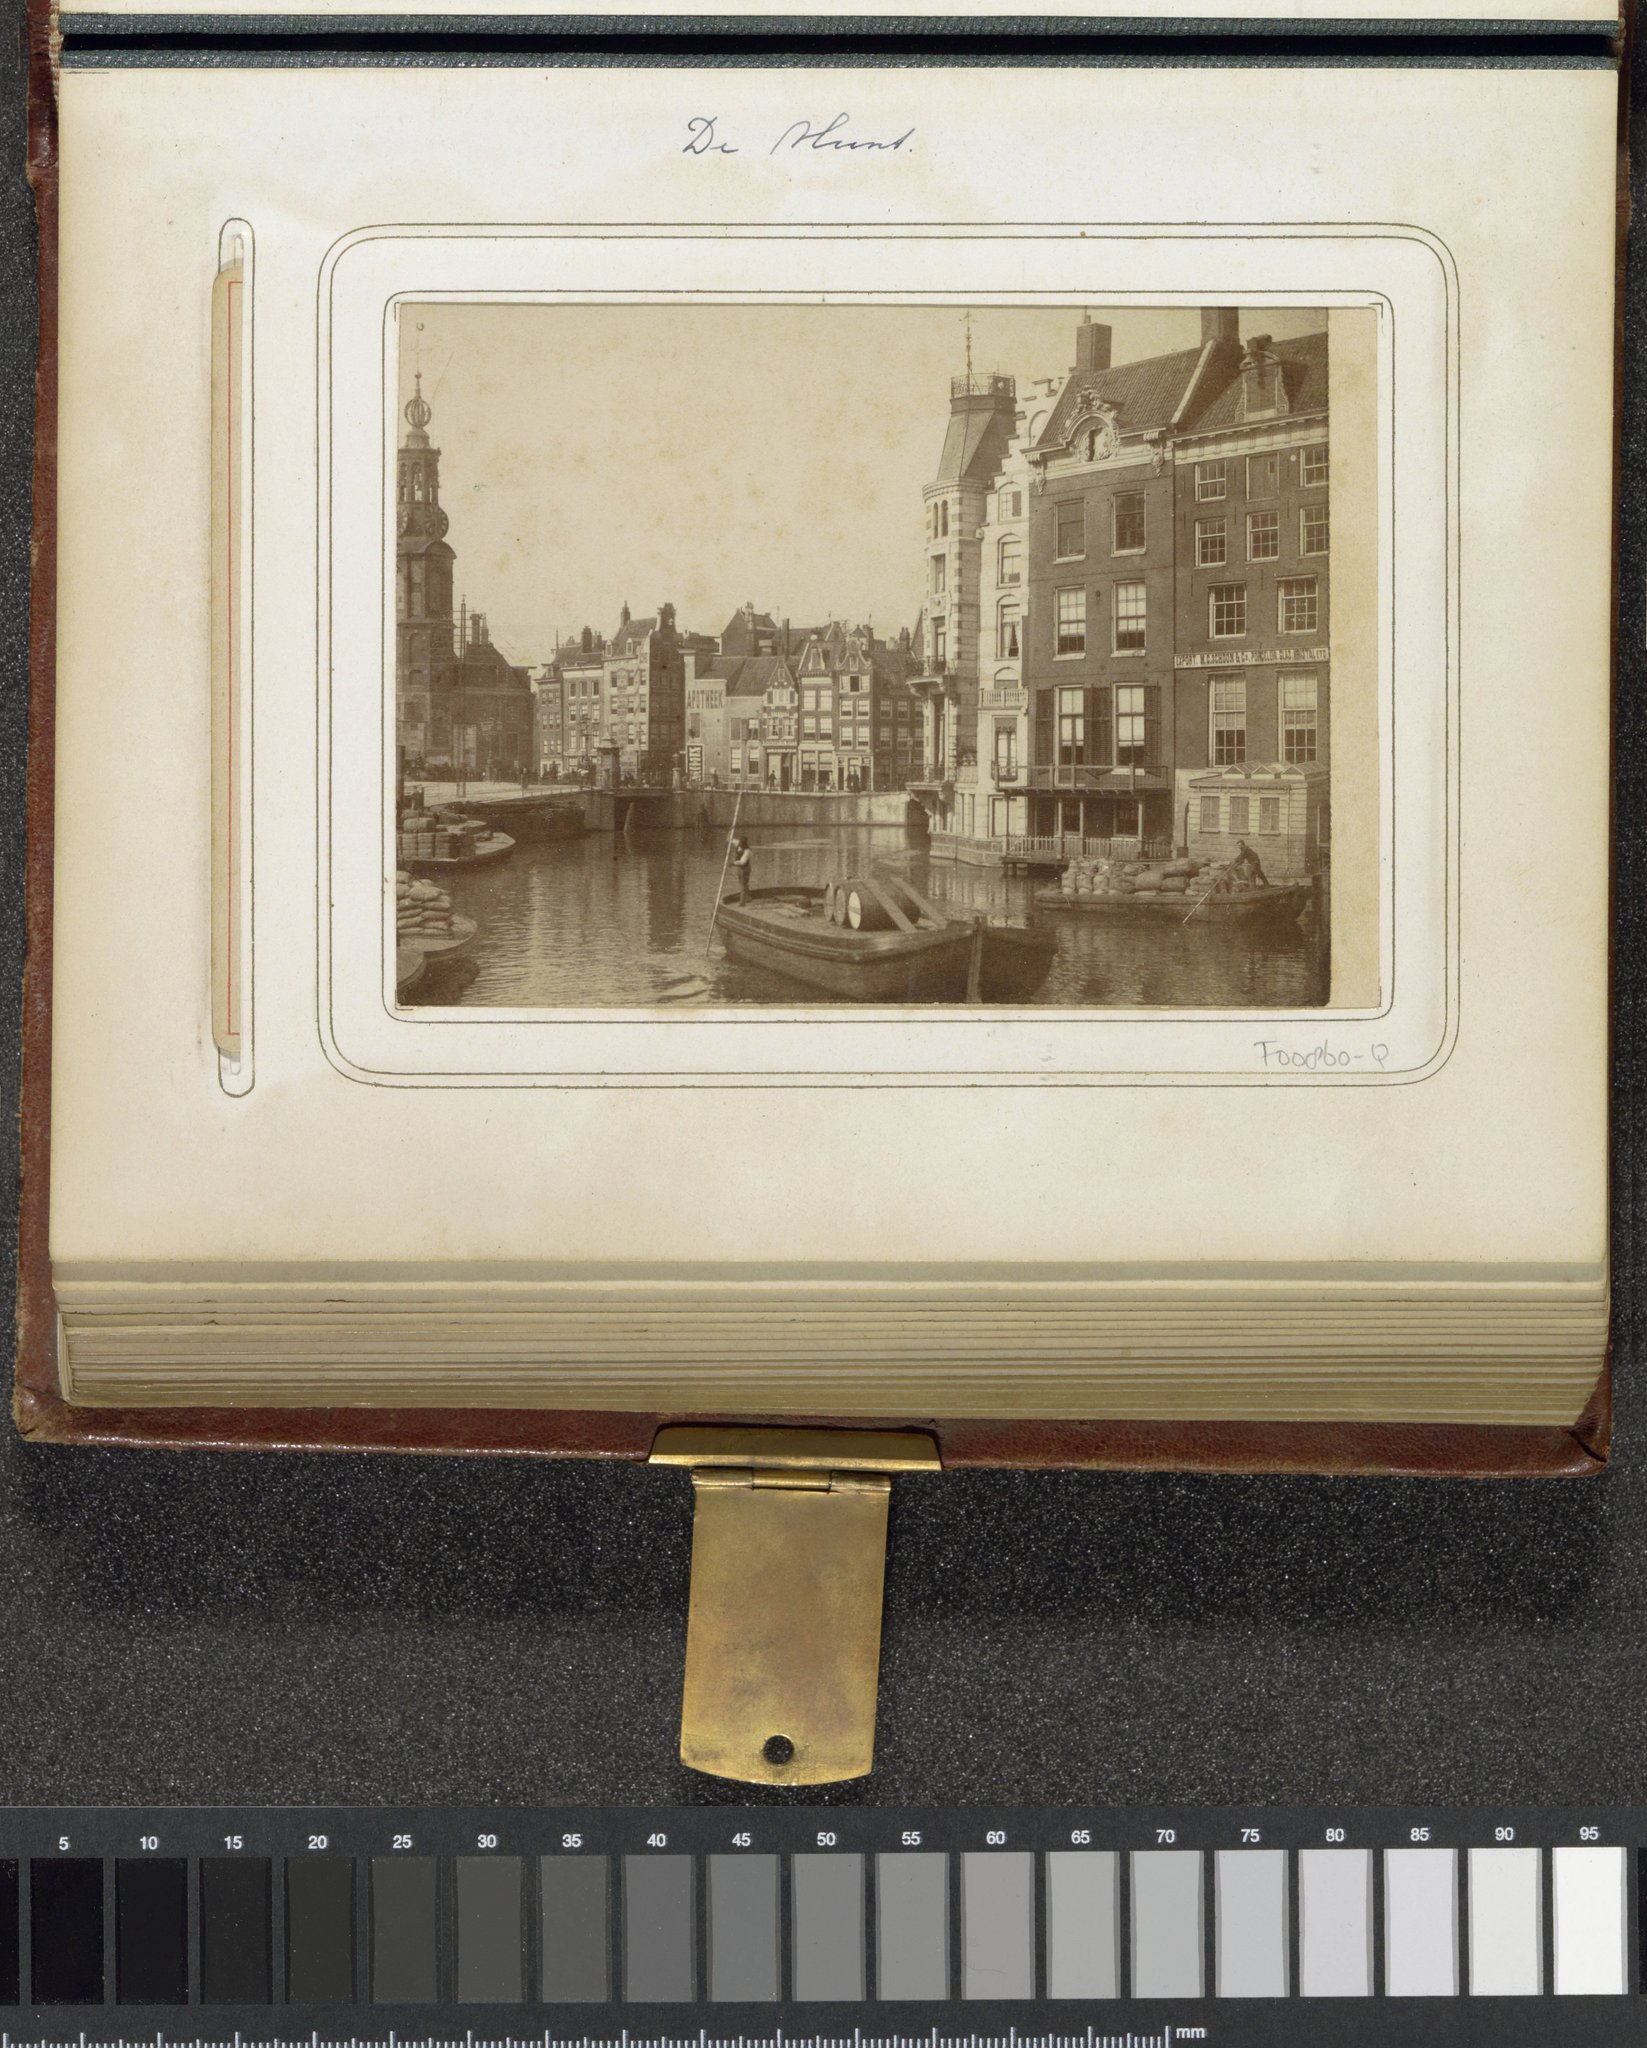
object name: cabinet photograph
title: Gezicht op de Munttoren met op de voorgrond dekschuiten op de Amstel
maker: andreas theodorus rooswinkel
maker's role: fotograaf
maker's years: 1838-1909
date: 1877-1890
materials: cardboard, paper, photographic support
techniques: albumen print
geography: amsterdam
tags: freight vessel, canals, waters (in city), façade (of house or building), city-gate, prospect of city, town panorama, silhouette of city, amsterdam